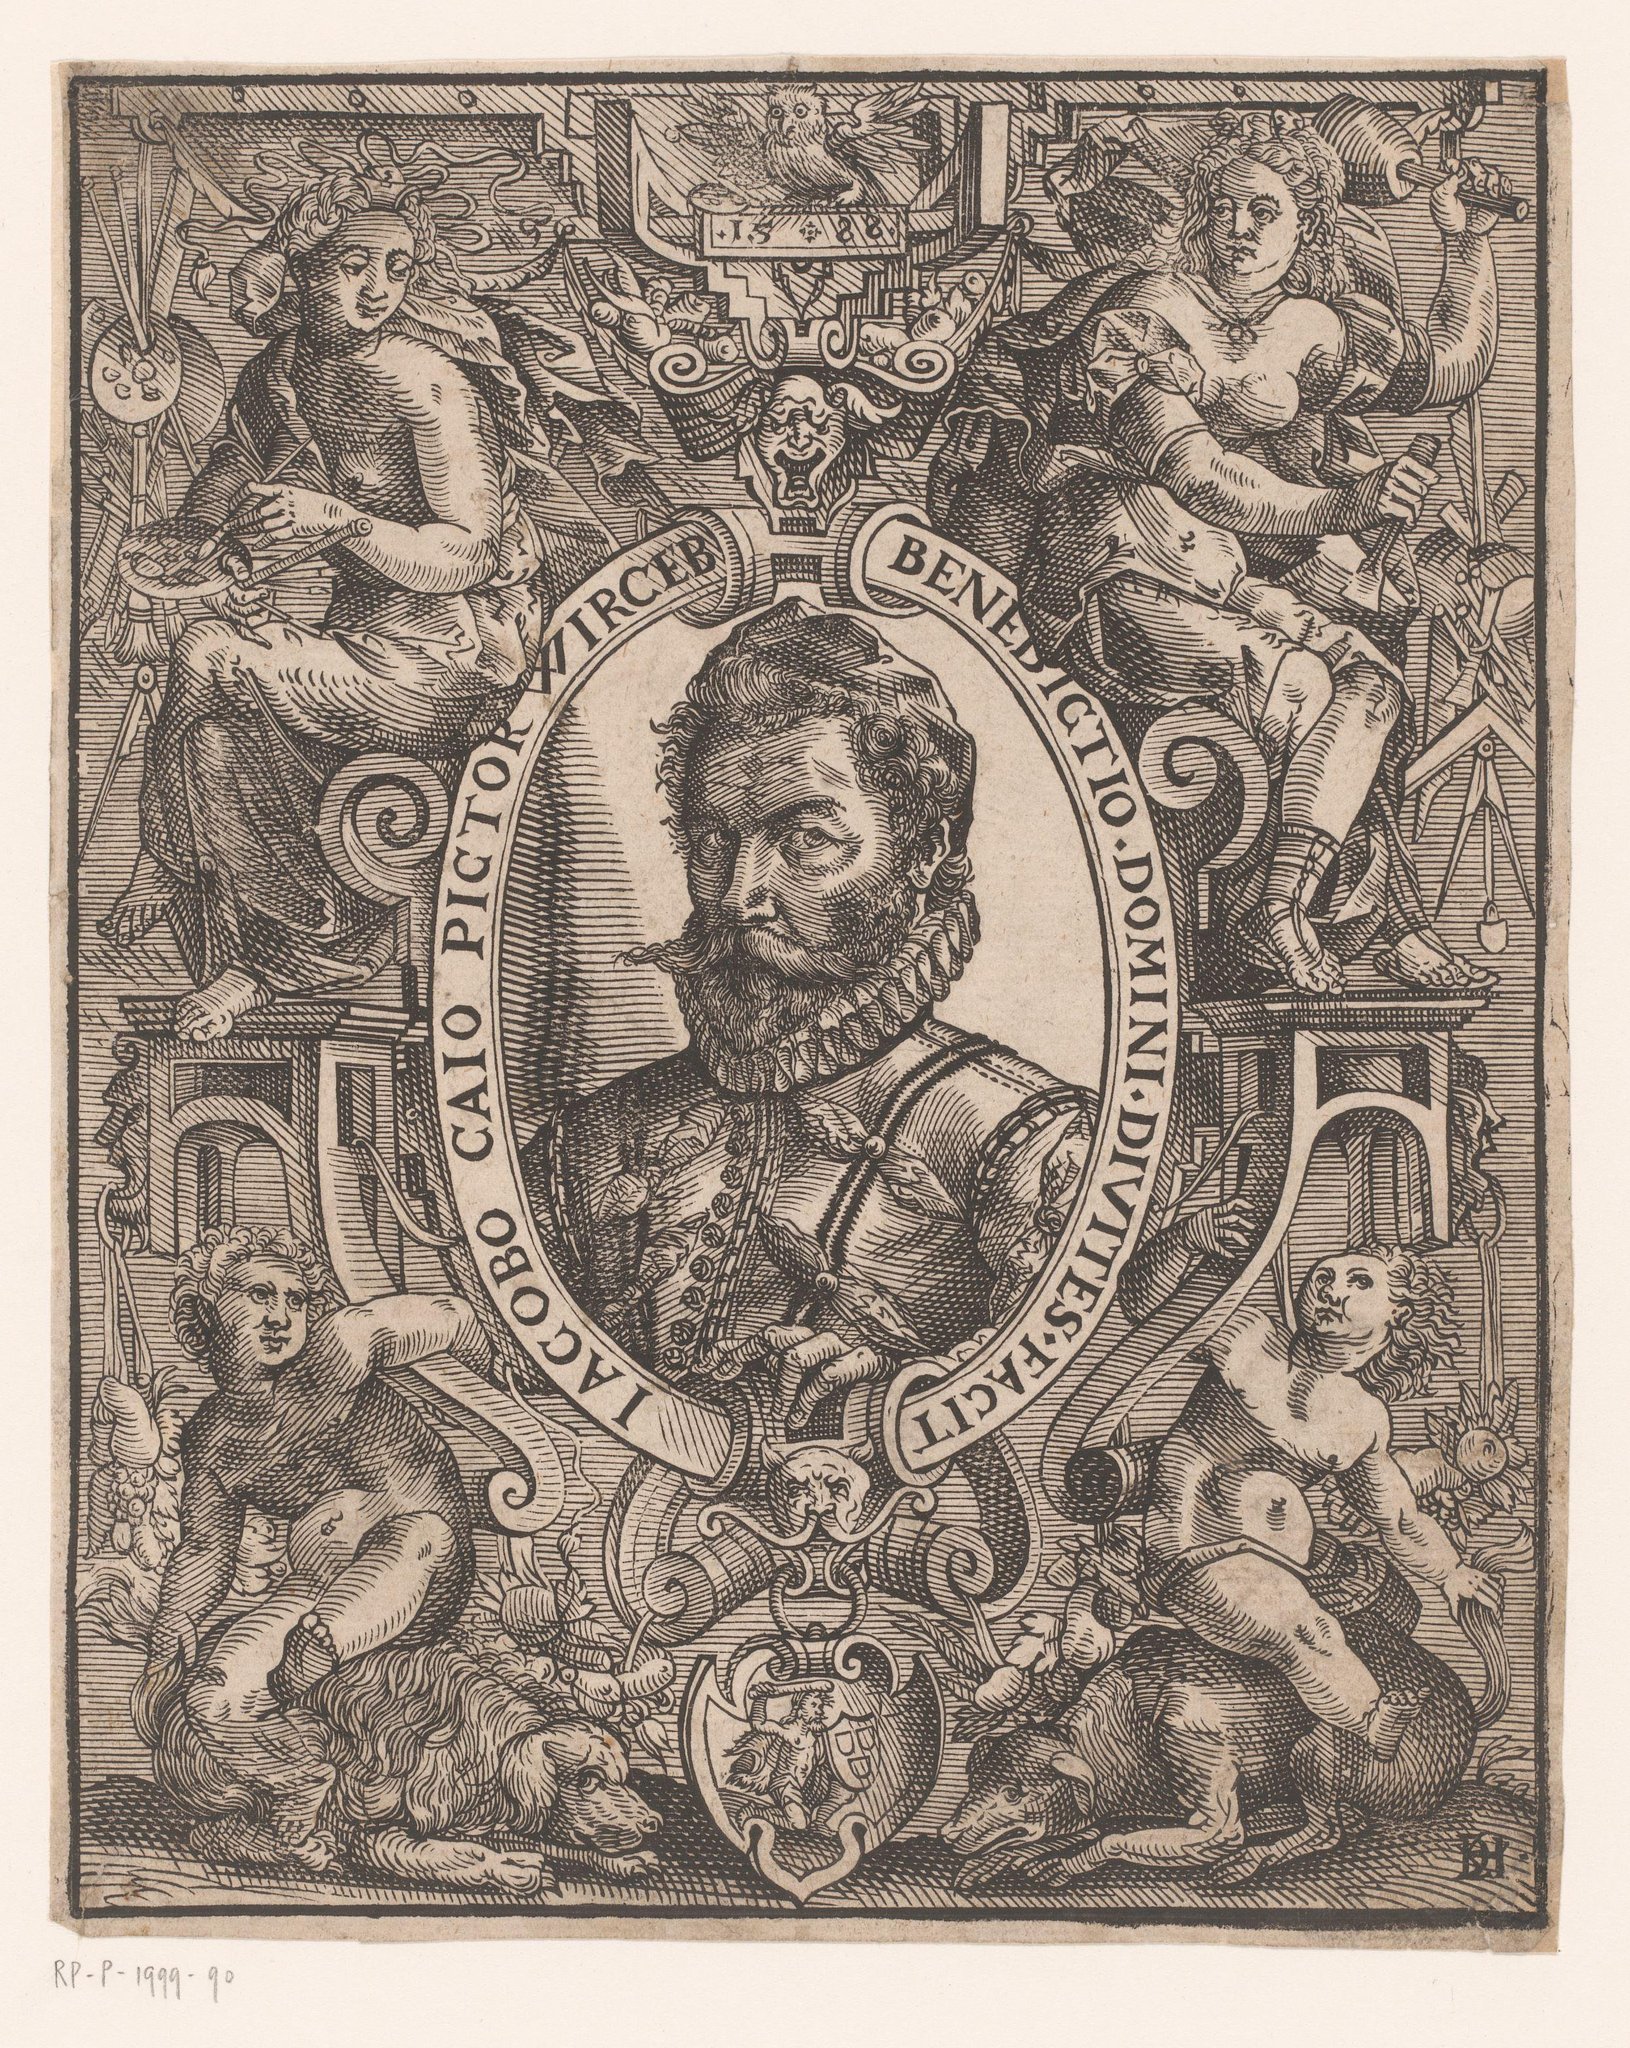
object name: print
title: Portret van Jacob Cay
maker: monogrammist dh (duitsland)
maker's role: print maker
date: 1588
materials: paper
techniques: woodcut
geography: germany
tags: painter, print maker, jacob cay, 'pictura', symbolic representations, allegories and emblems ~ painting; 'pittura' (ripa), 'sculptura', symbolic representations, allegories and emblems ~ sculpture; 'scoltura' (ripa), portrait, self-portrait of painter, tools, implements of painter, tools, implements of sculptor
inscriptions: collector's mark: Lugt 2228, collector's mark: Lugt 2760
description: Portret in een ornamentele omlijsting, waaraan zijn wapen hangt. Omgeven door twee putti (links en rechtsonder), ieder zittend op een hond. Bovenaan links een personificatie van de schilderkunst en rechts de beeldhouwkunst. In het midden de uil van Minerva.